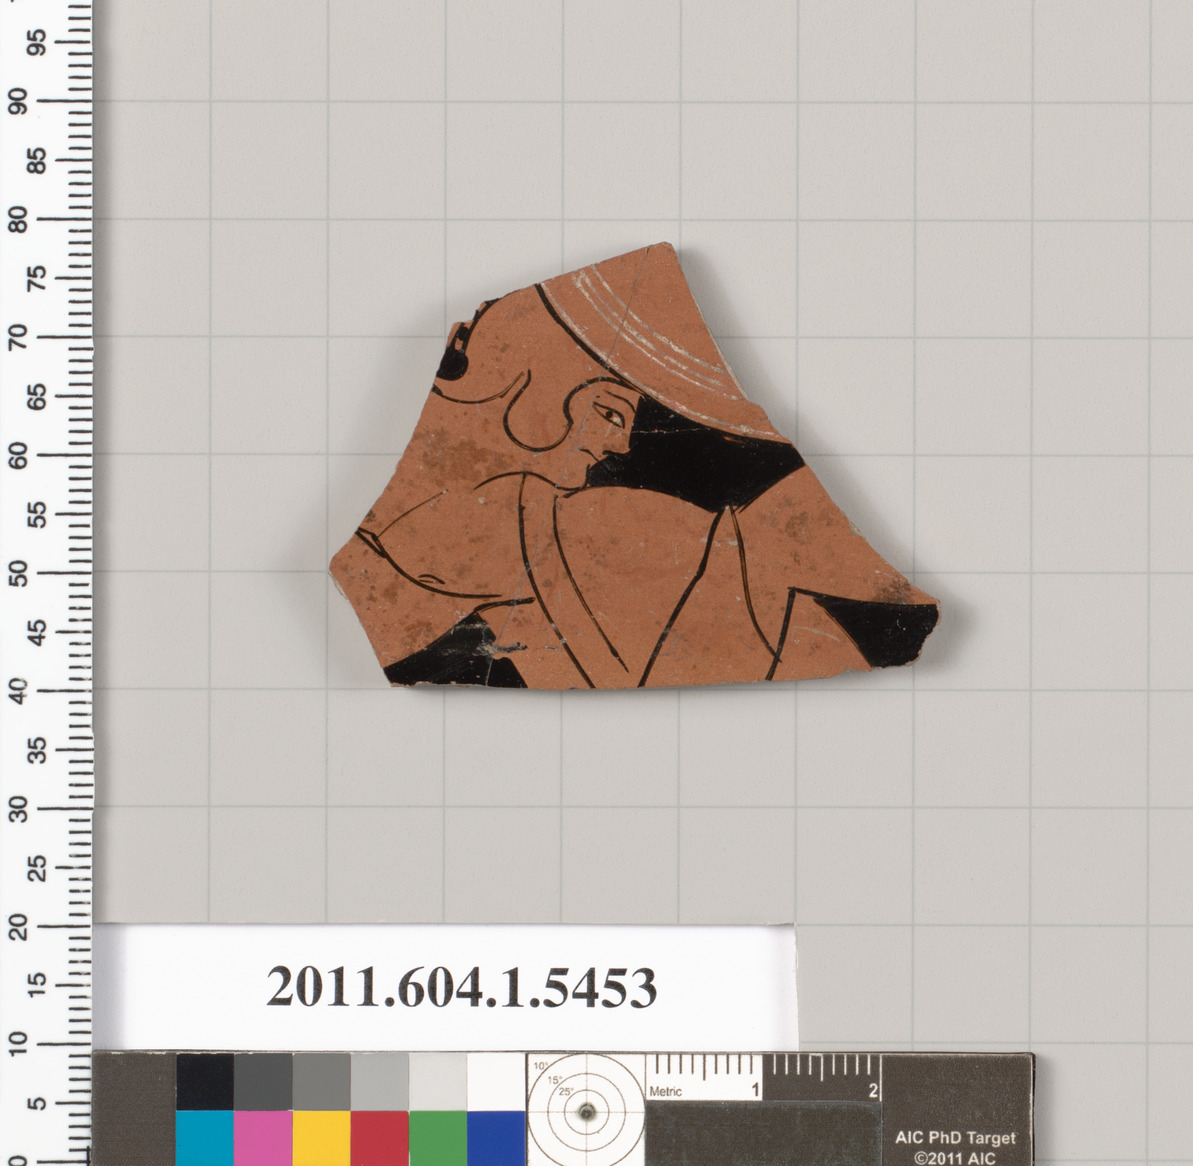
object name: kylix fragment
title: Terracotta fragment of a kylix (drinking cup)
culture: greek, attic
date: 510-500 BCE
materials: terracotta